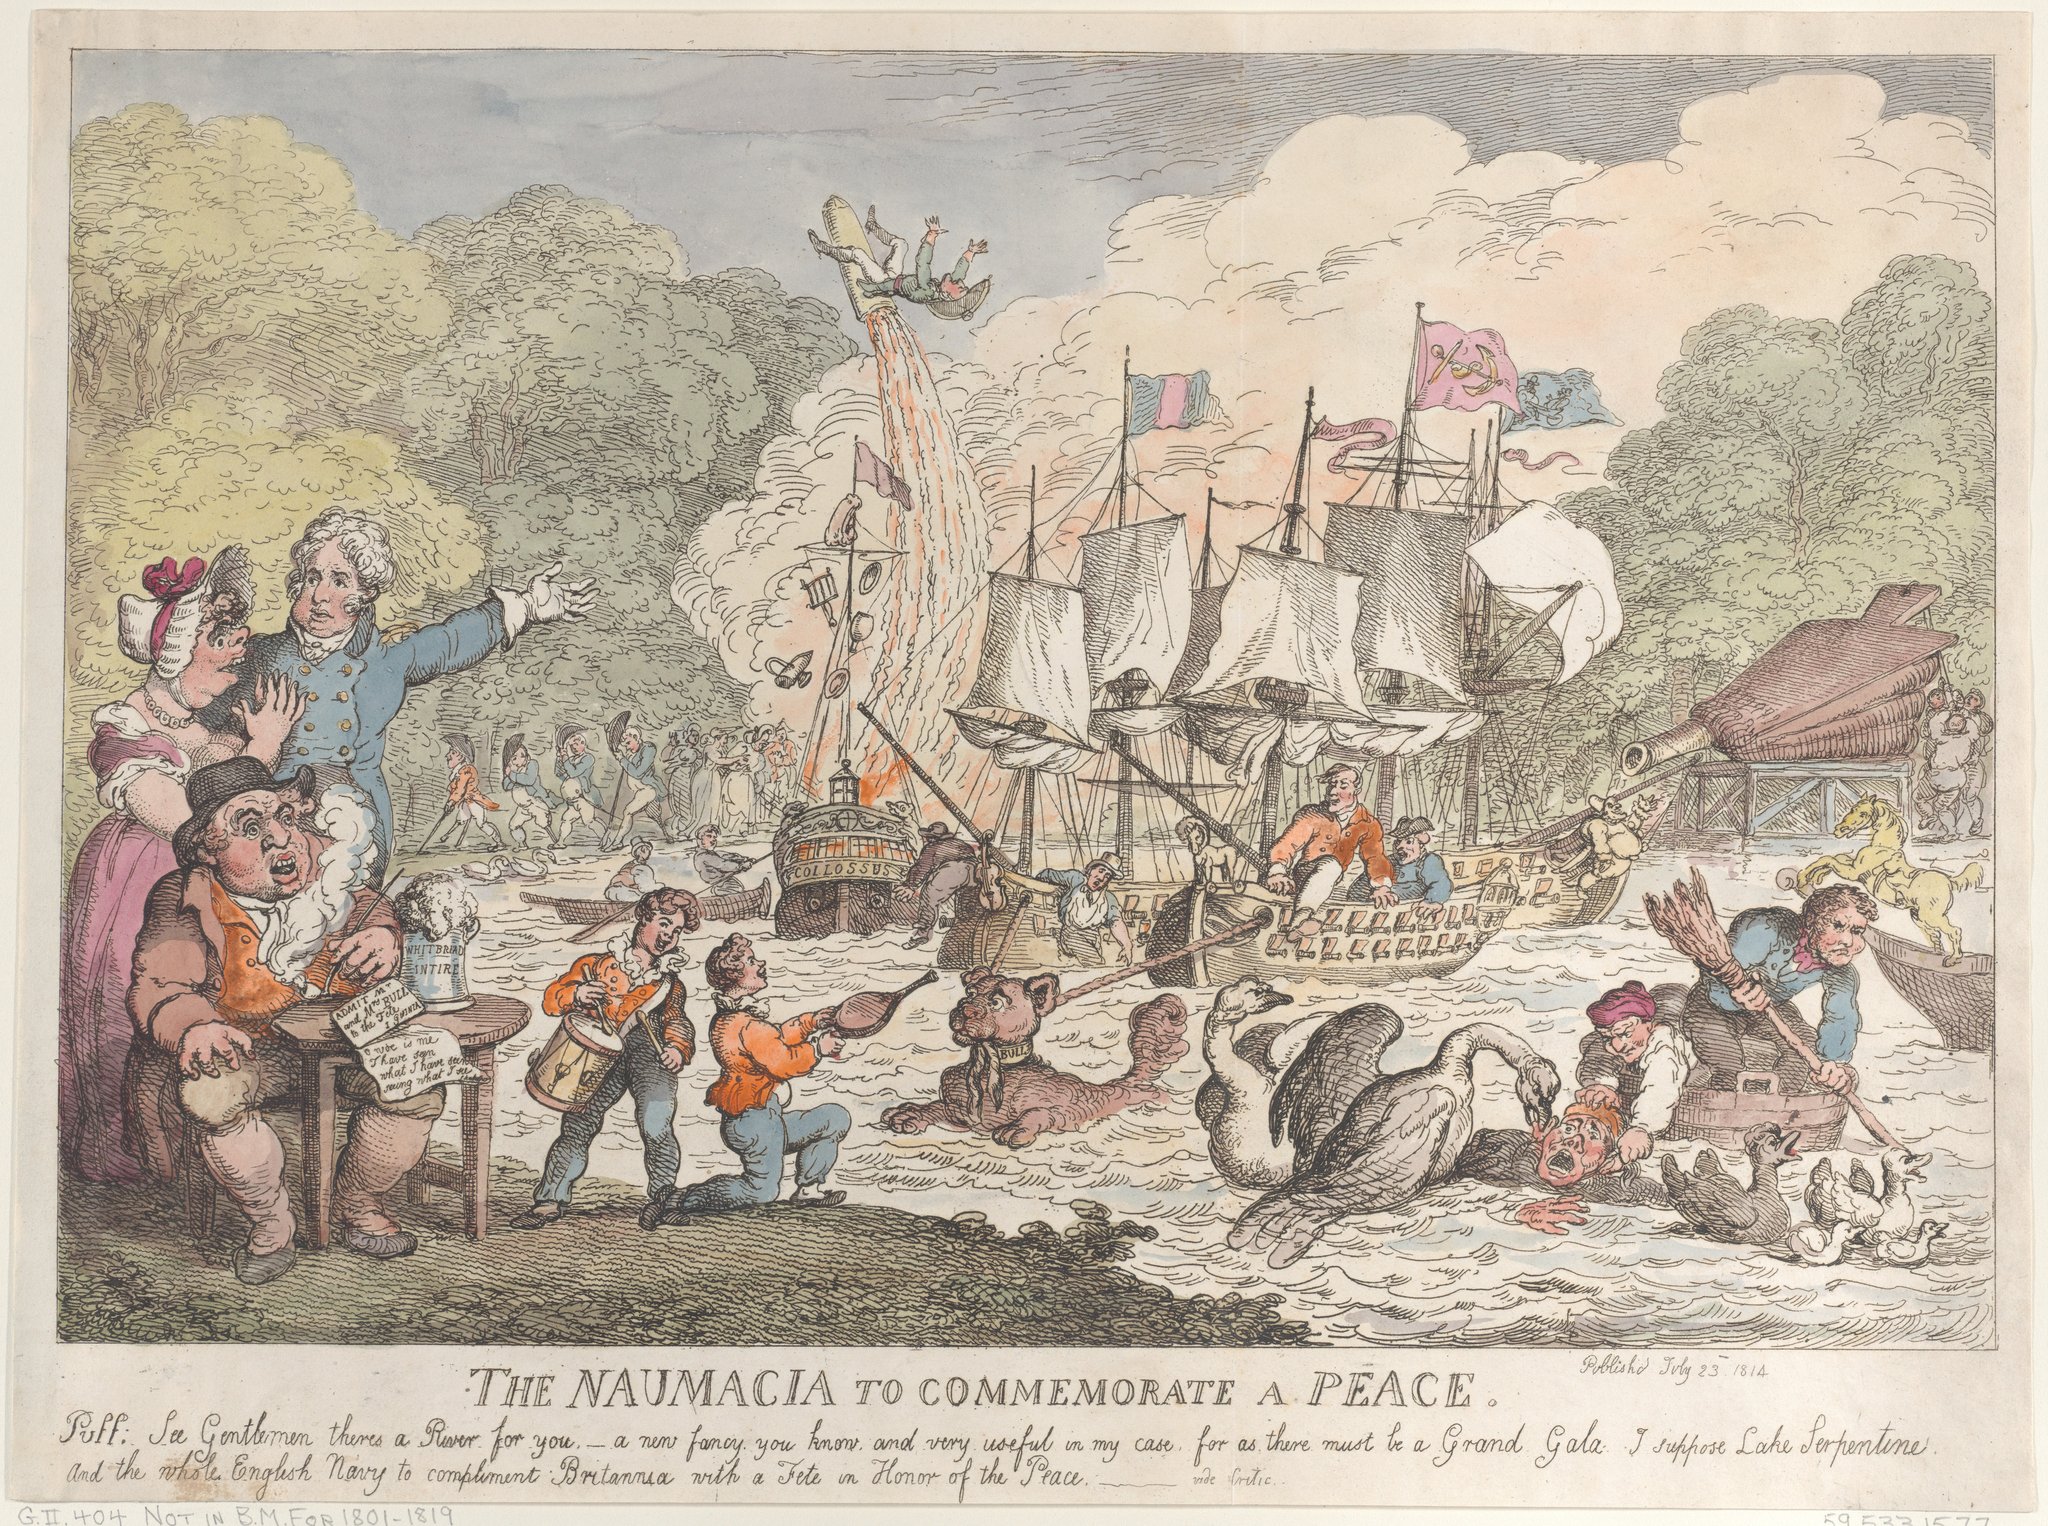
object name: print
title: The Naumacia to Commemorate a Peace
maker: thomas rowlandson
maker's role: artist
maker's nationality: british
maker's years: 1757-1827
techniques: etching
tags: satire,men,women,swans,dogs,ships